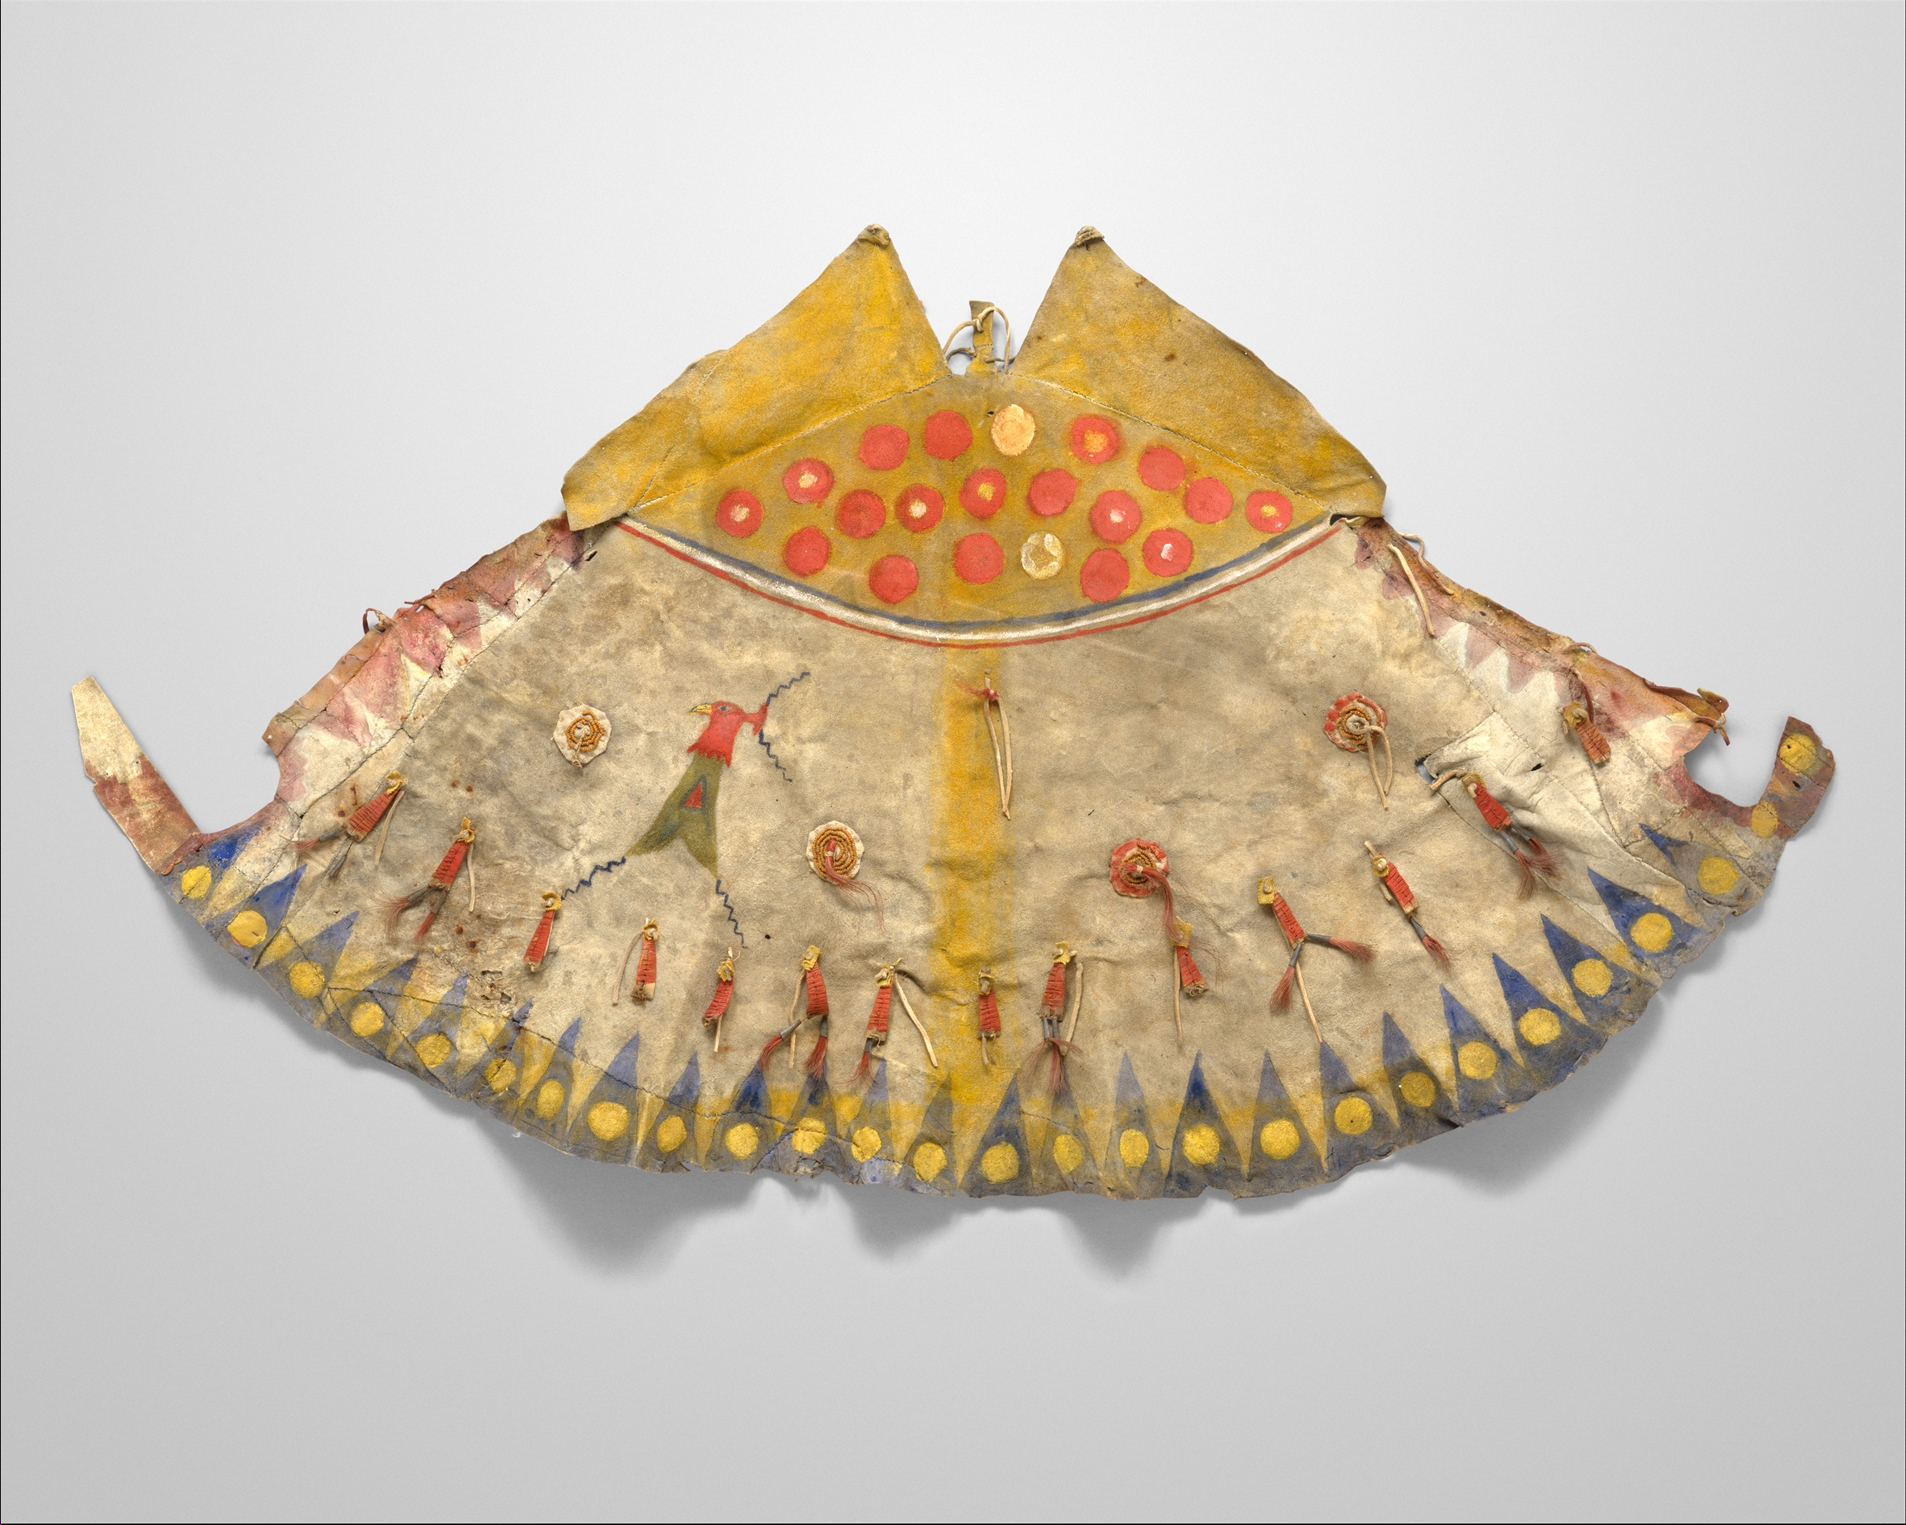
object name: tipi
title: Model Tipi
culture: blackfoot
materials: textile, hair, paint, skin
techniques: tanning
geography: canada